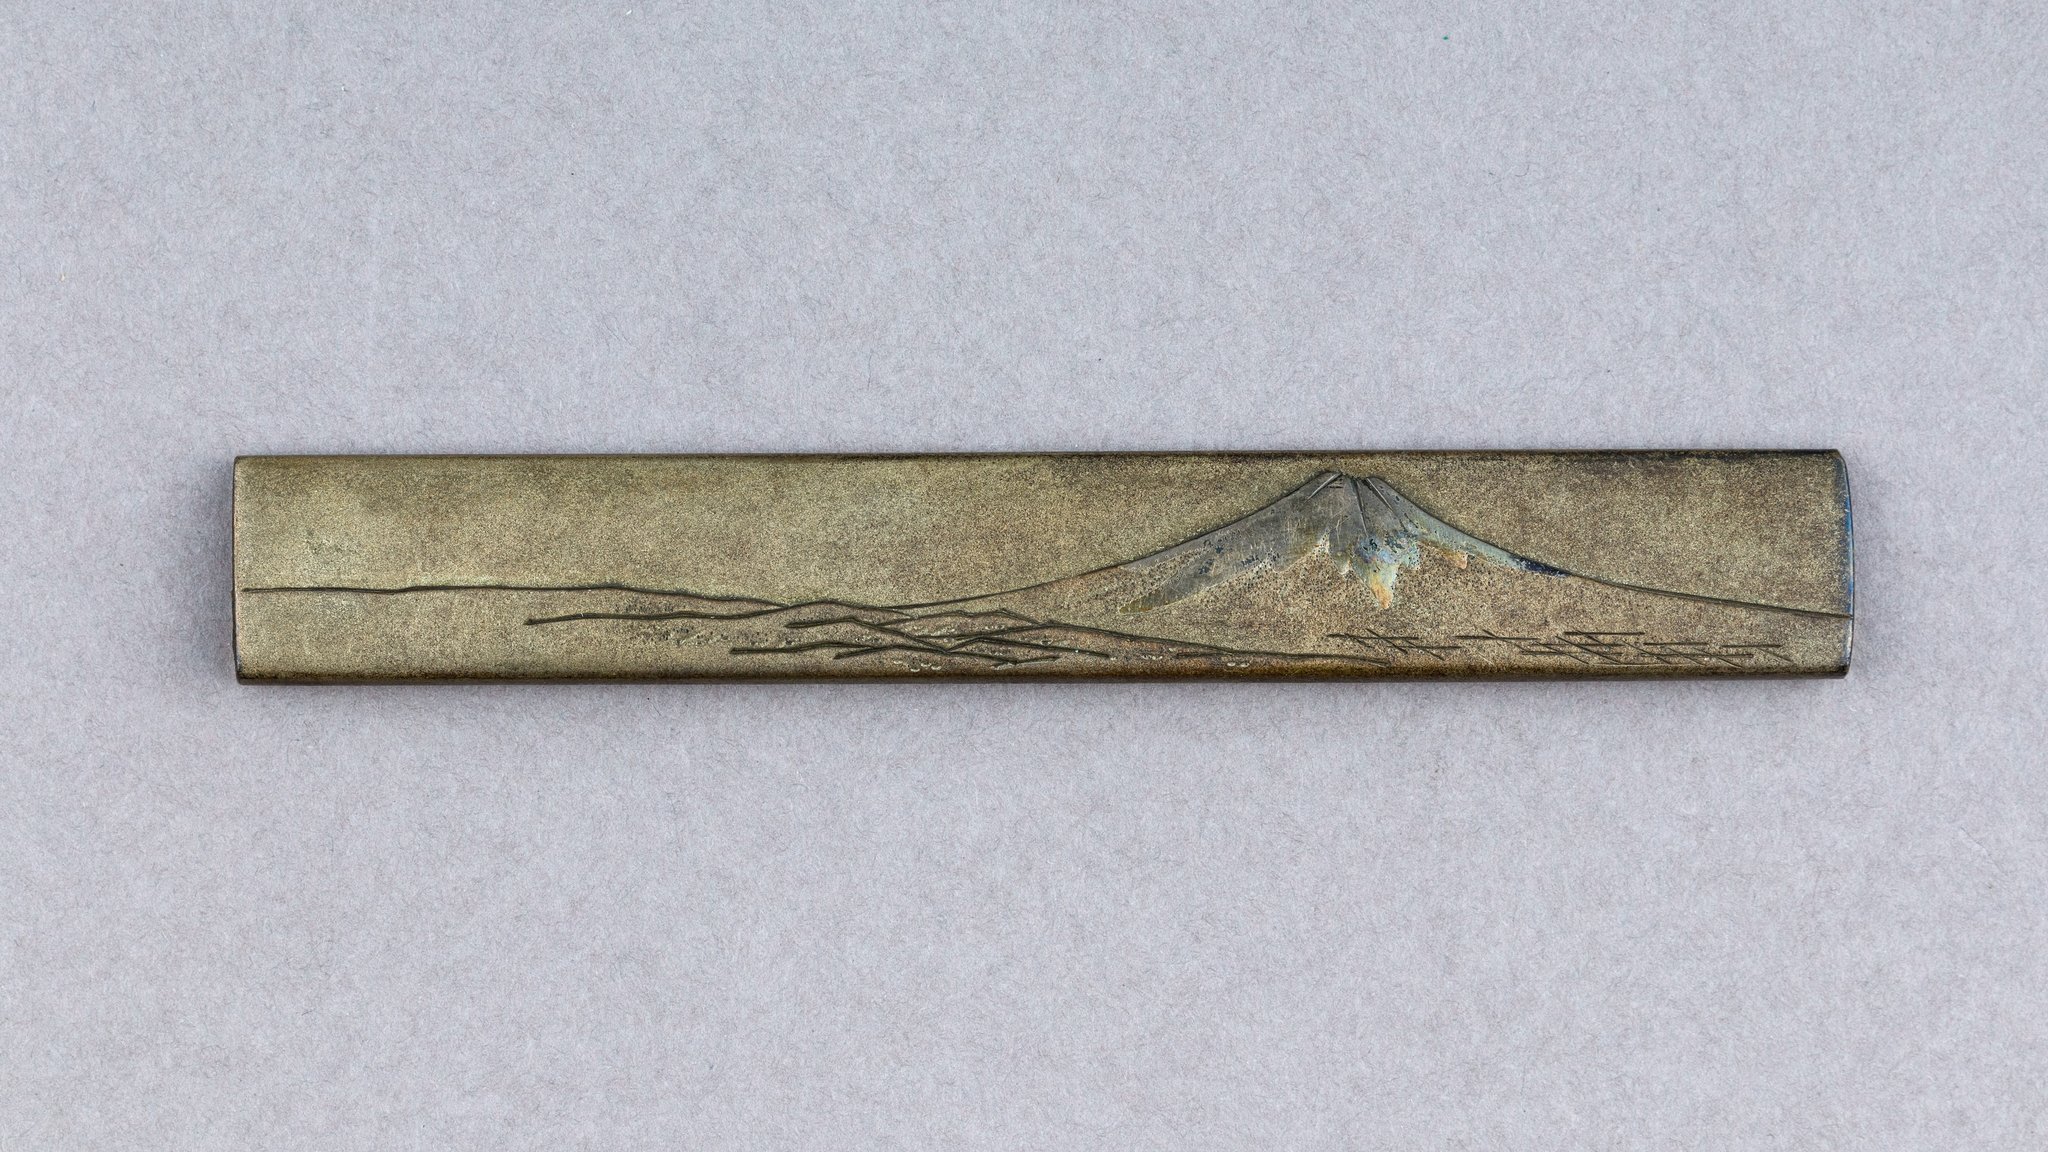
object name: knife handle kozuka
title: Knife Handle (Kozuka)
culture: japanese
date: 1615-1868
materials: silver alloy, gold, silver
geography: japan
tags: mountains